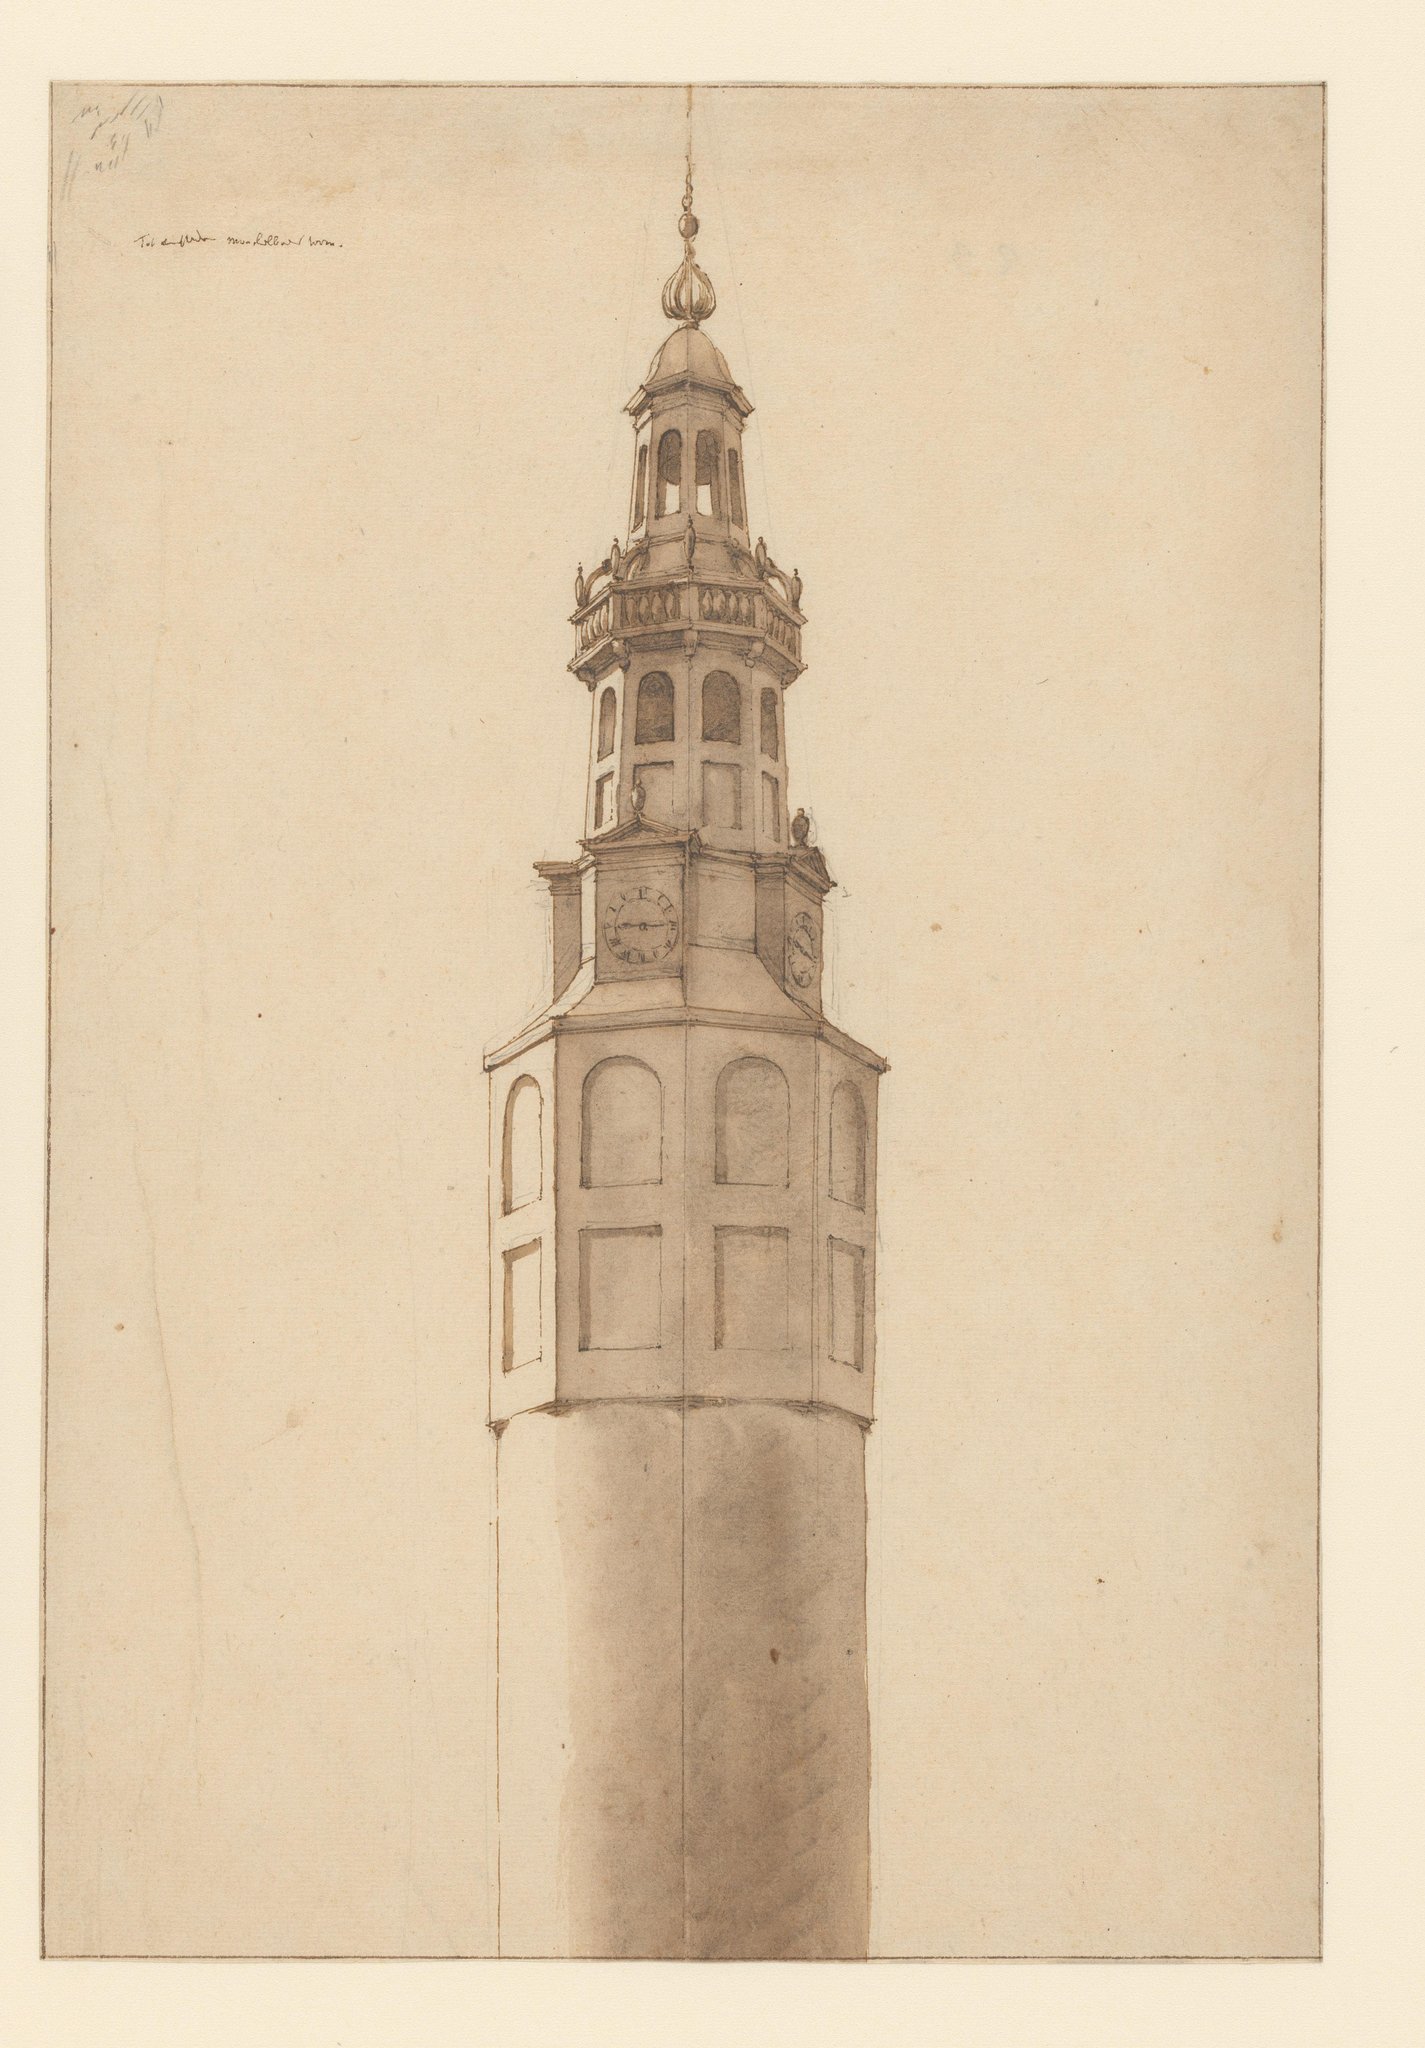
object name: print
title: Gezicht op de Munttoren te Amsterdam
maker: jan spaan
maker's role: print maker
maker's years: 1742-1828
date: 1767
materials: paper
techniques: etching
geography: northern netherlands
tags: tower, clock tower ~ monumental adornment, street (+ city(-scape) with figures, staffage)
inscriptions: collector's mark: Lugt 1641b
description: Onderwerpsrubriek binnen de Atlas Amsterdam: Reguliers- of Munttoren.